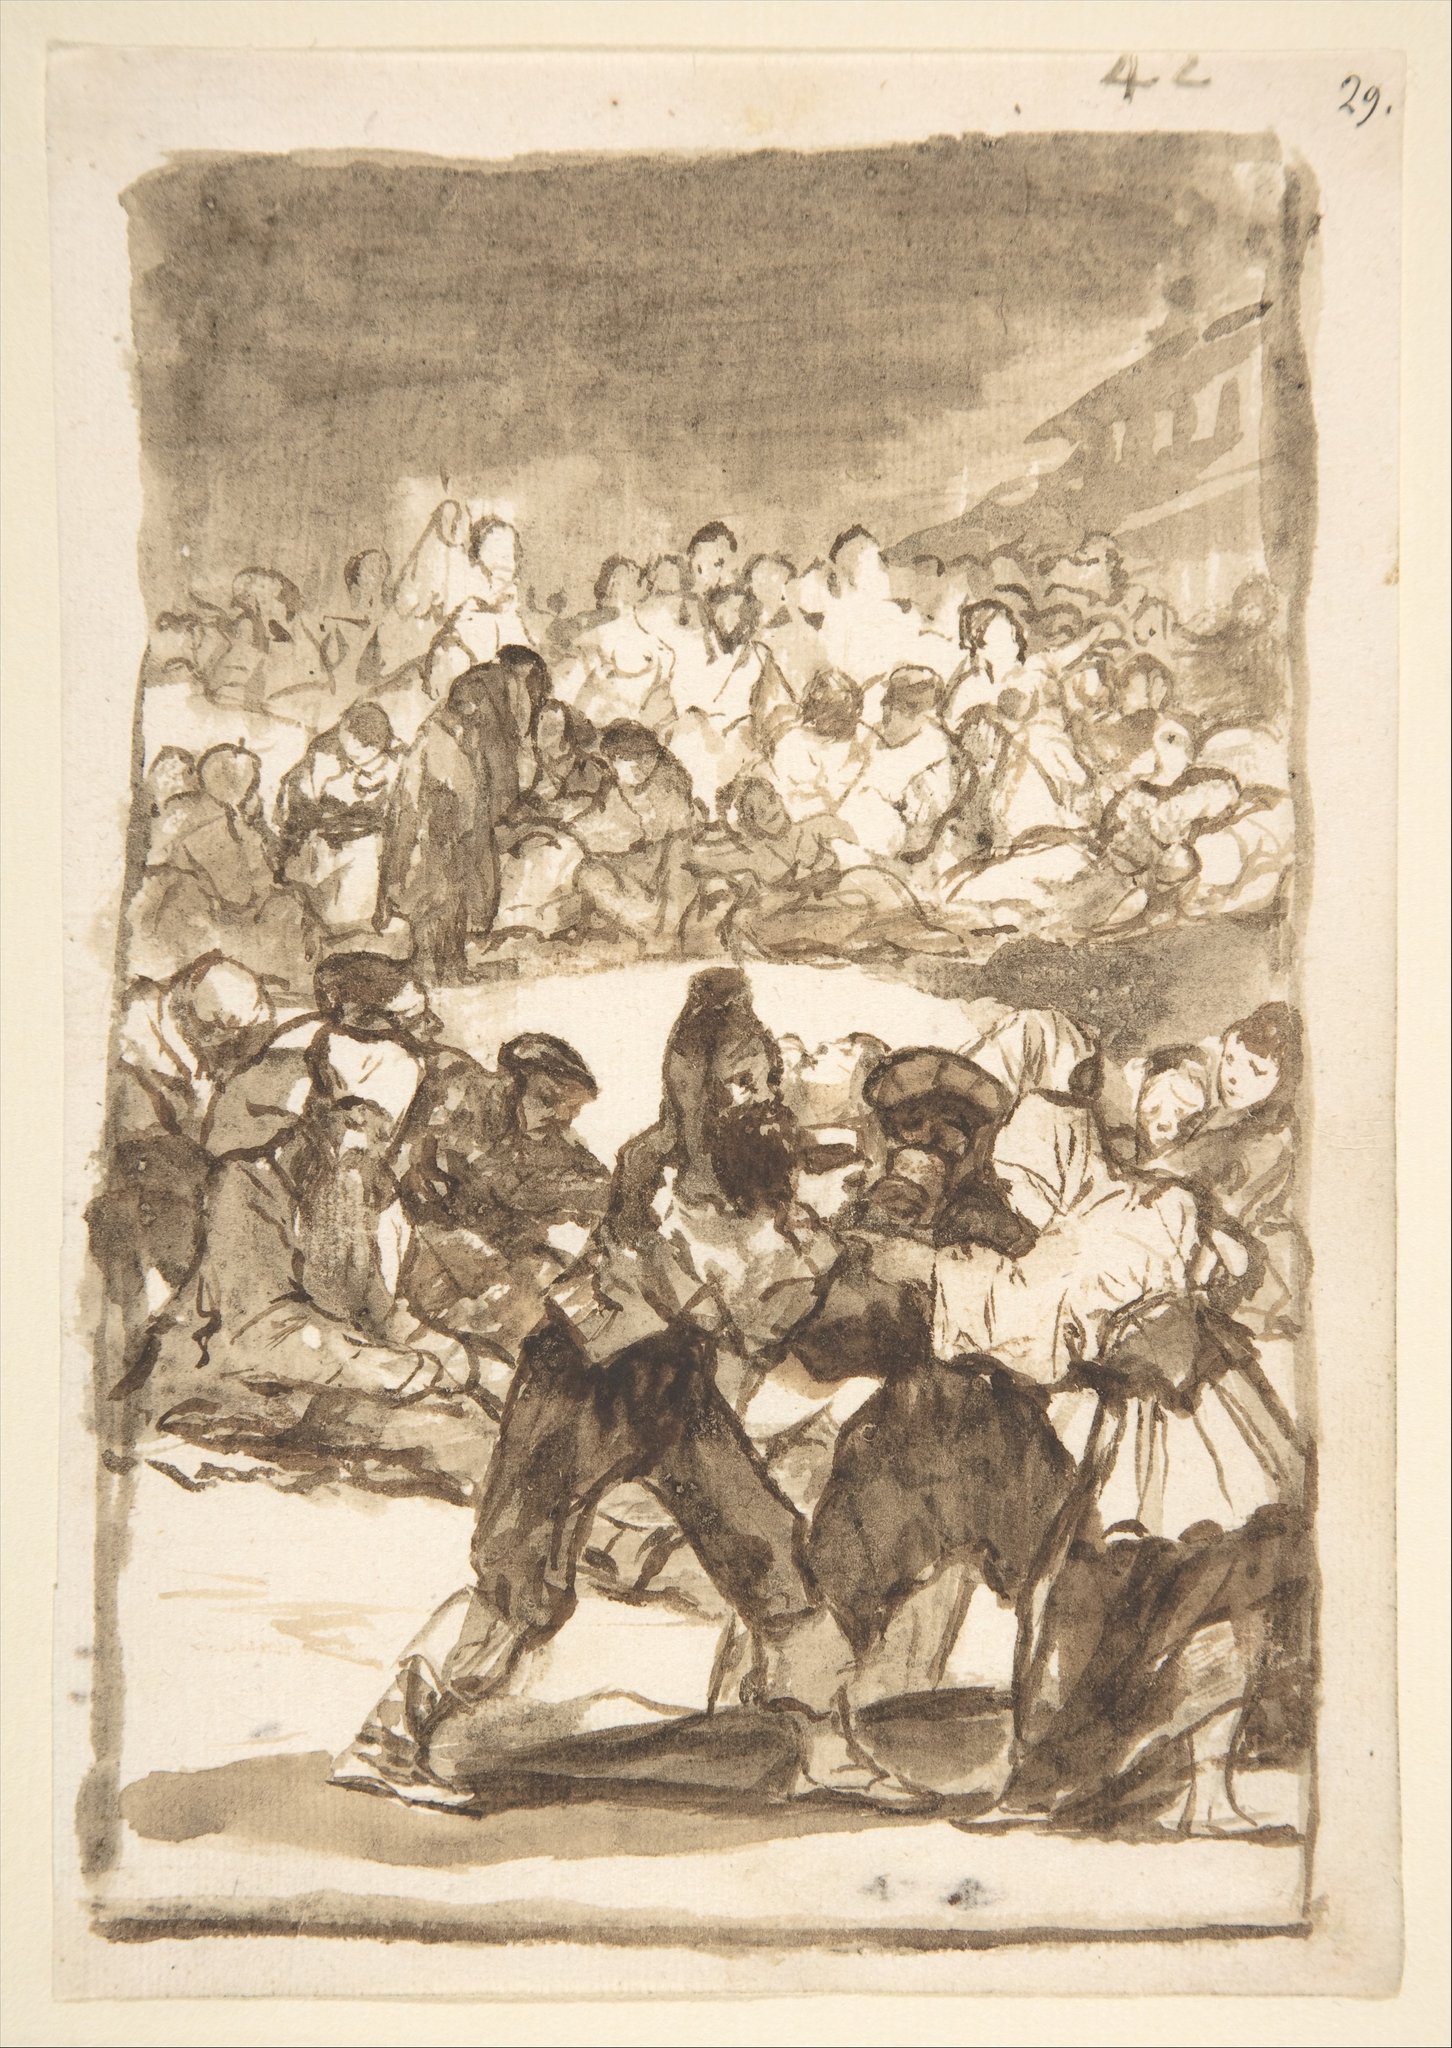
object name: drawing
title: A crowd forming a circle; page 42 from the "Images of Spain" album (F)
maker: goya (francisco de goya y lucientes)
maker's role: artist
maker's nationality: spanish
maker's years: 1746-1828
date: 1812-1820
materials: chalk, ink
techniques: brush, wash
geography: spain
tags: crowd